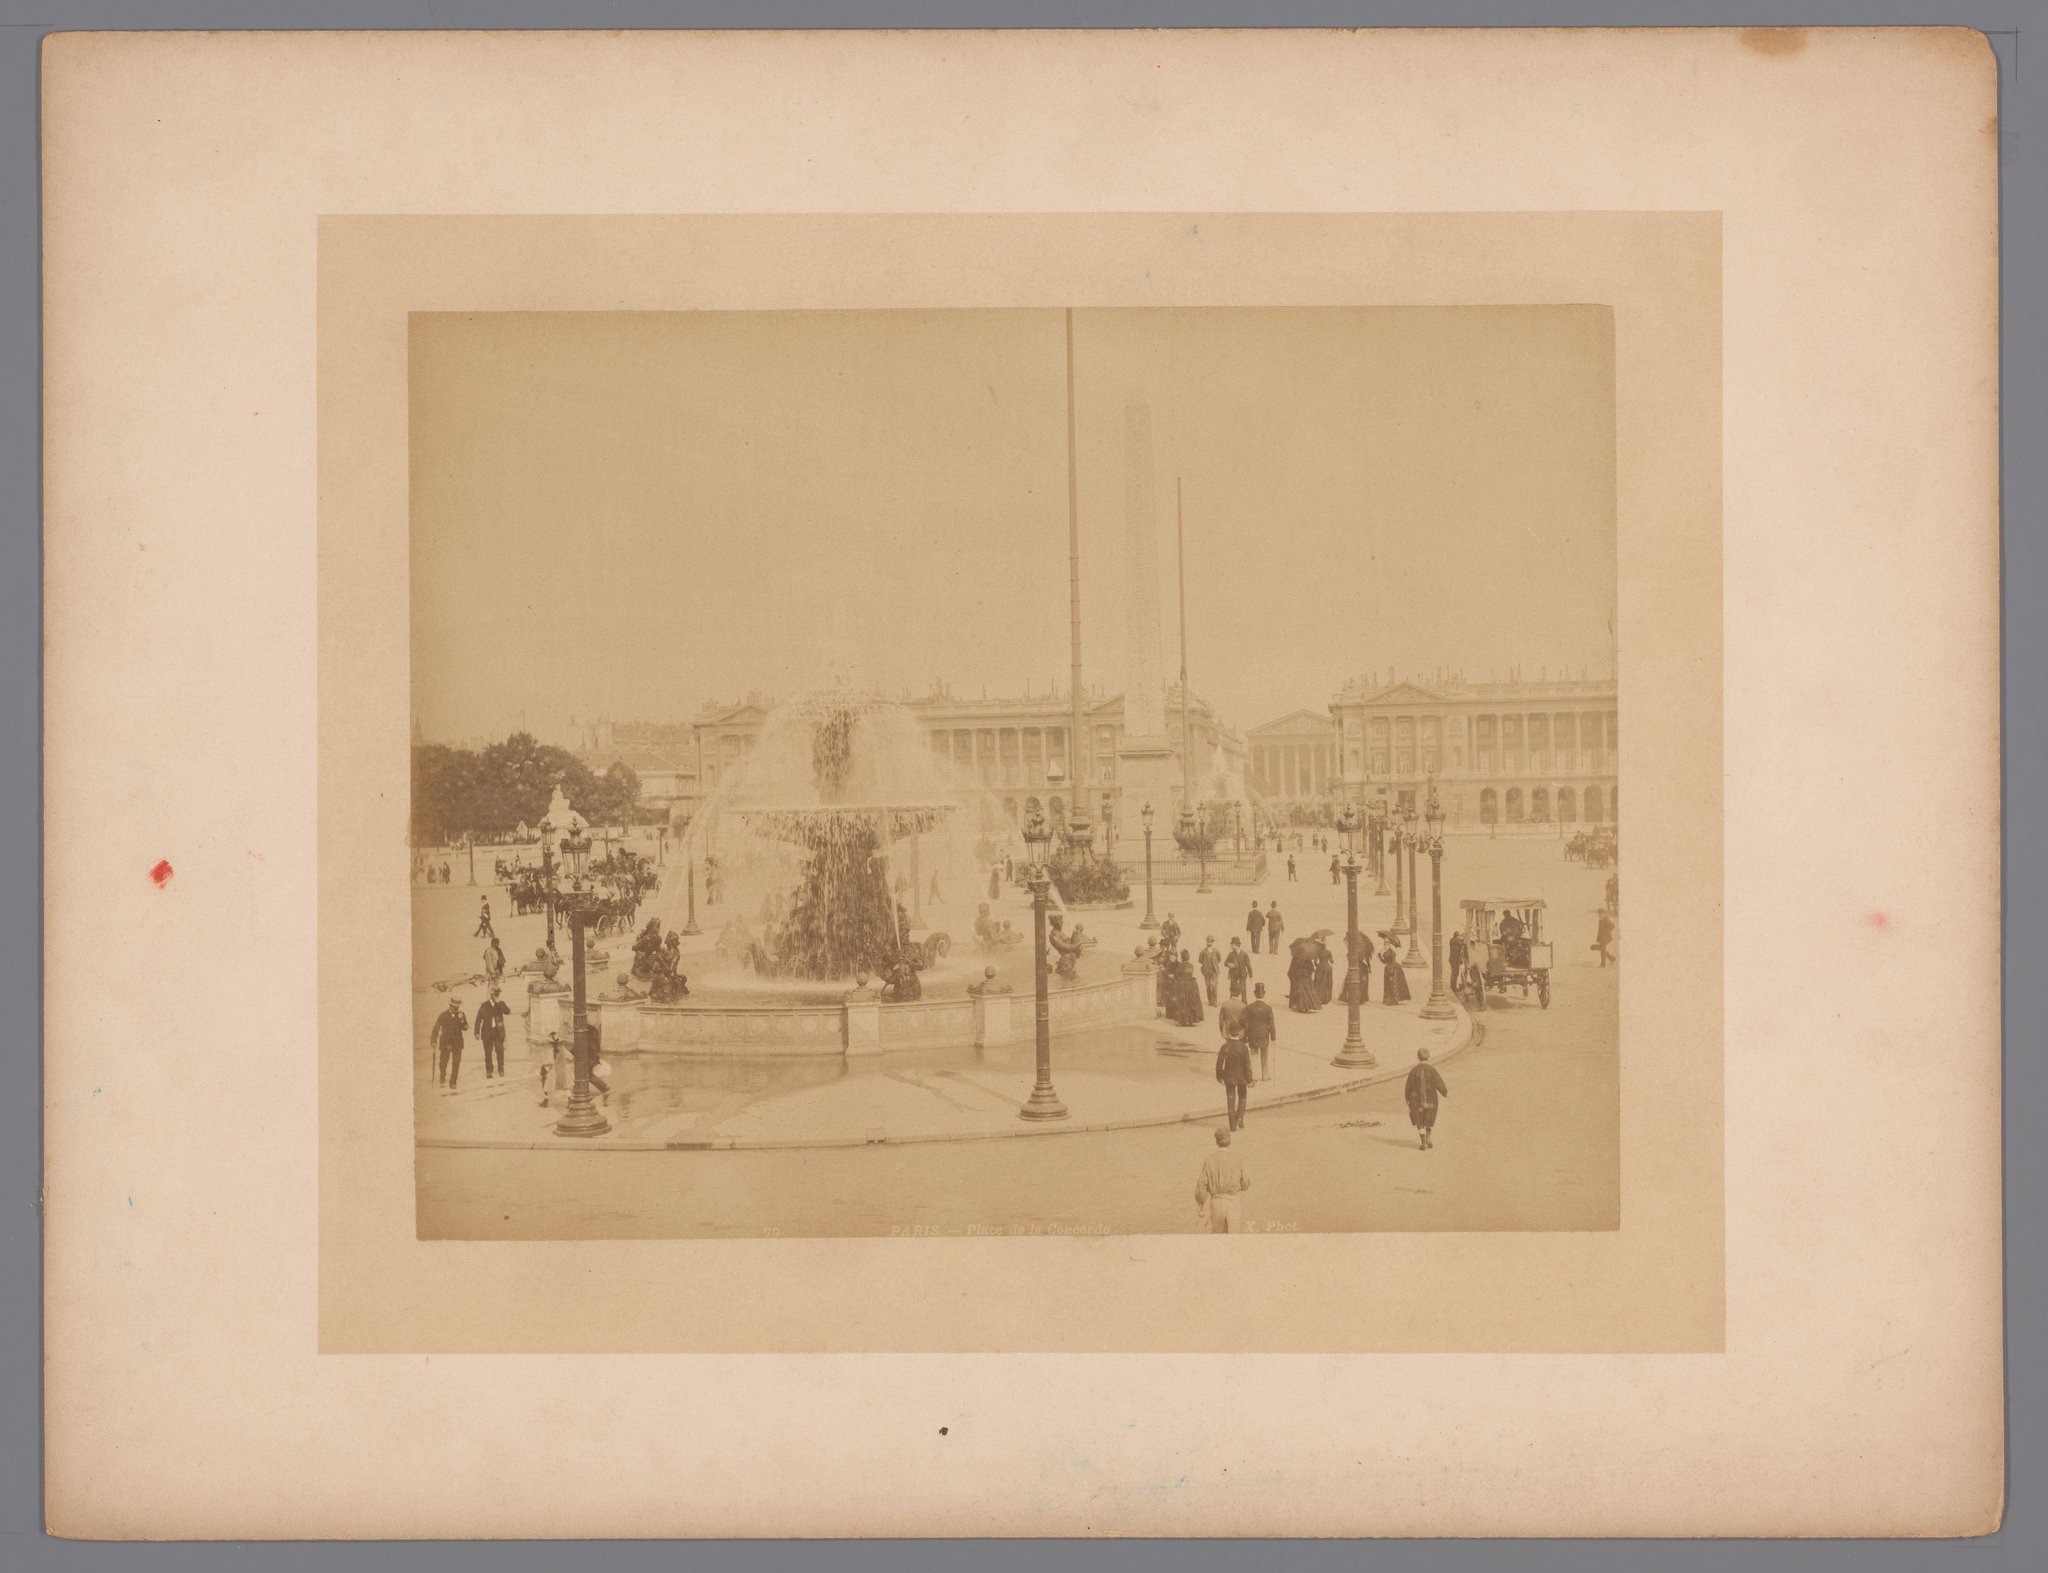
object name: photograph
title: Place de la Concorde, Parijs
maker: Anonymous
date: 1870-1900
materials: cardboard, paper, photographic support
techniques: albumen print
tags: place de la concorde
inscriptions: signature: ‘X. Phot.’, number: ‘19.’, inscription: ‘79 PARIS - Place de la Concorde’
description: Gezicht op het plein met een grote fontein in het midden en passanten.